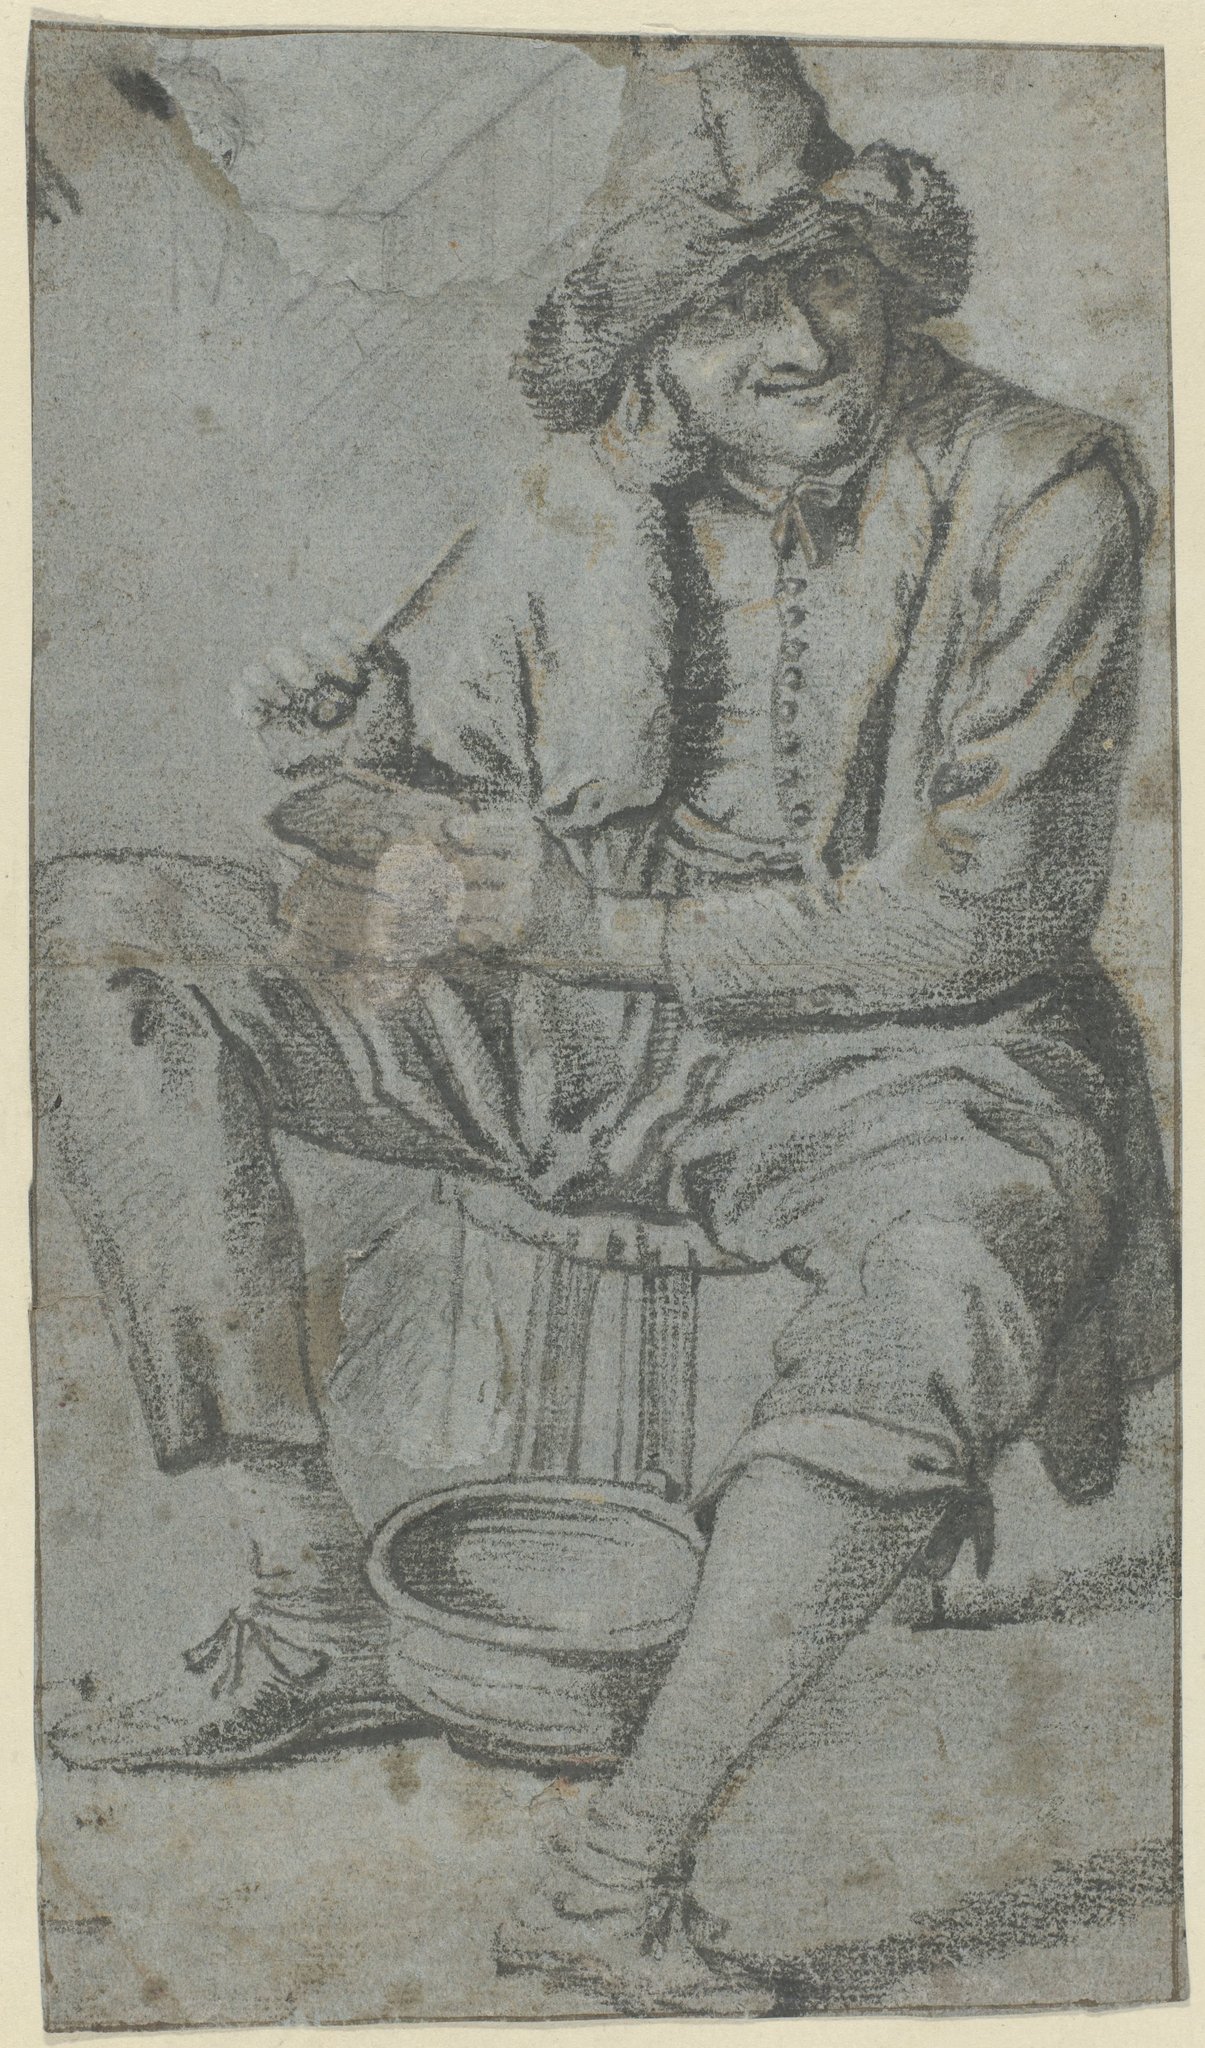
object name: drawing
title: Op kruk gezeten man met pijp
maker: Anonymous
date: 1600-1699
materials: chalk, charcoal, paper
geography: netherlands